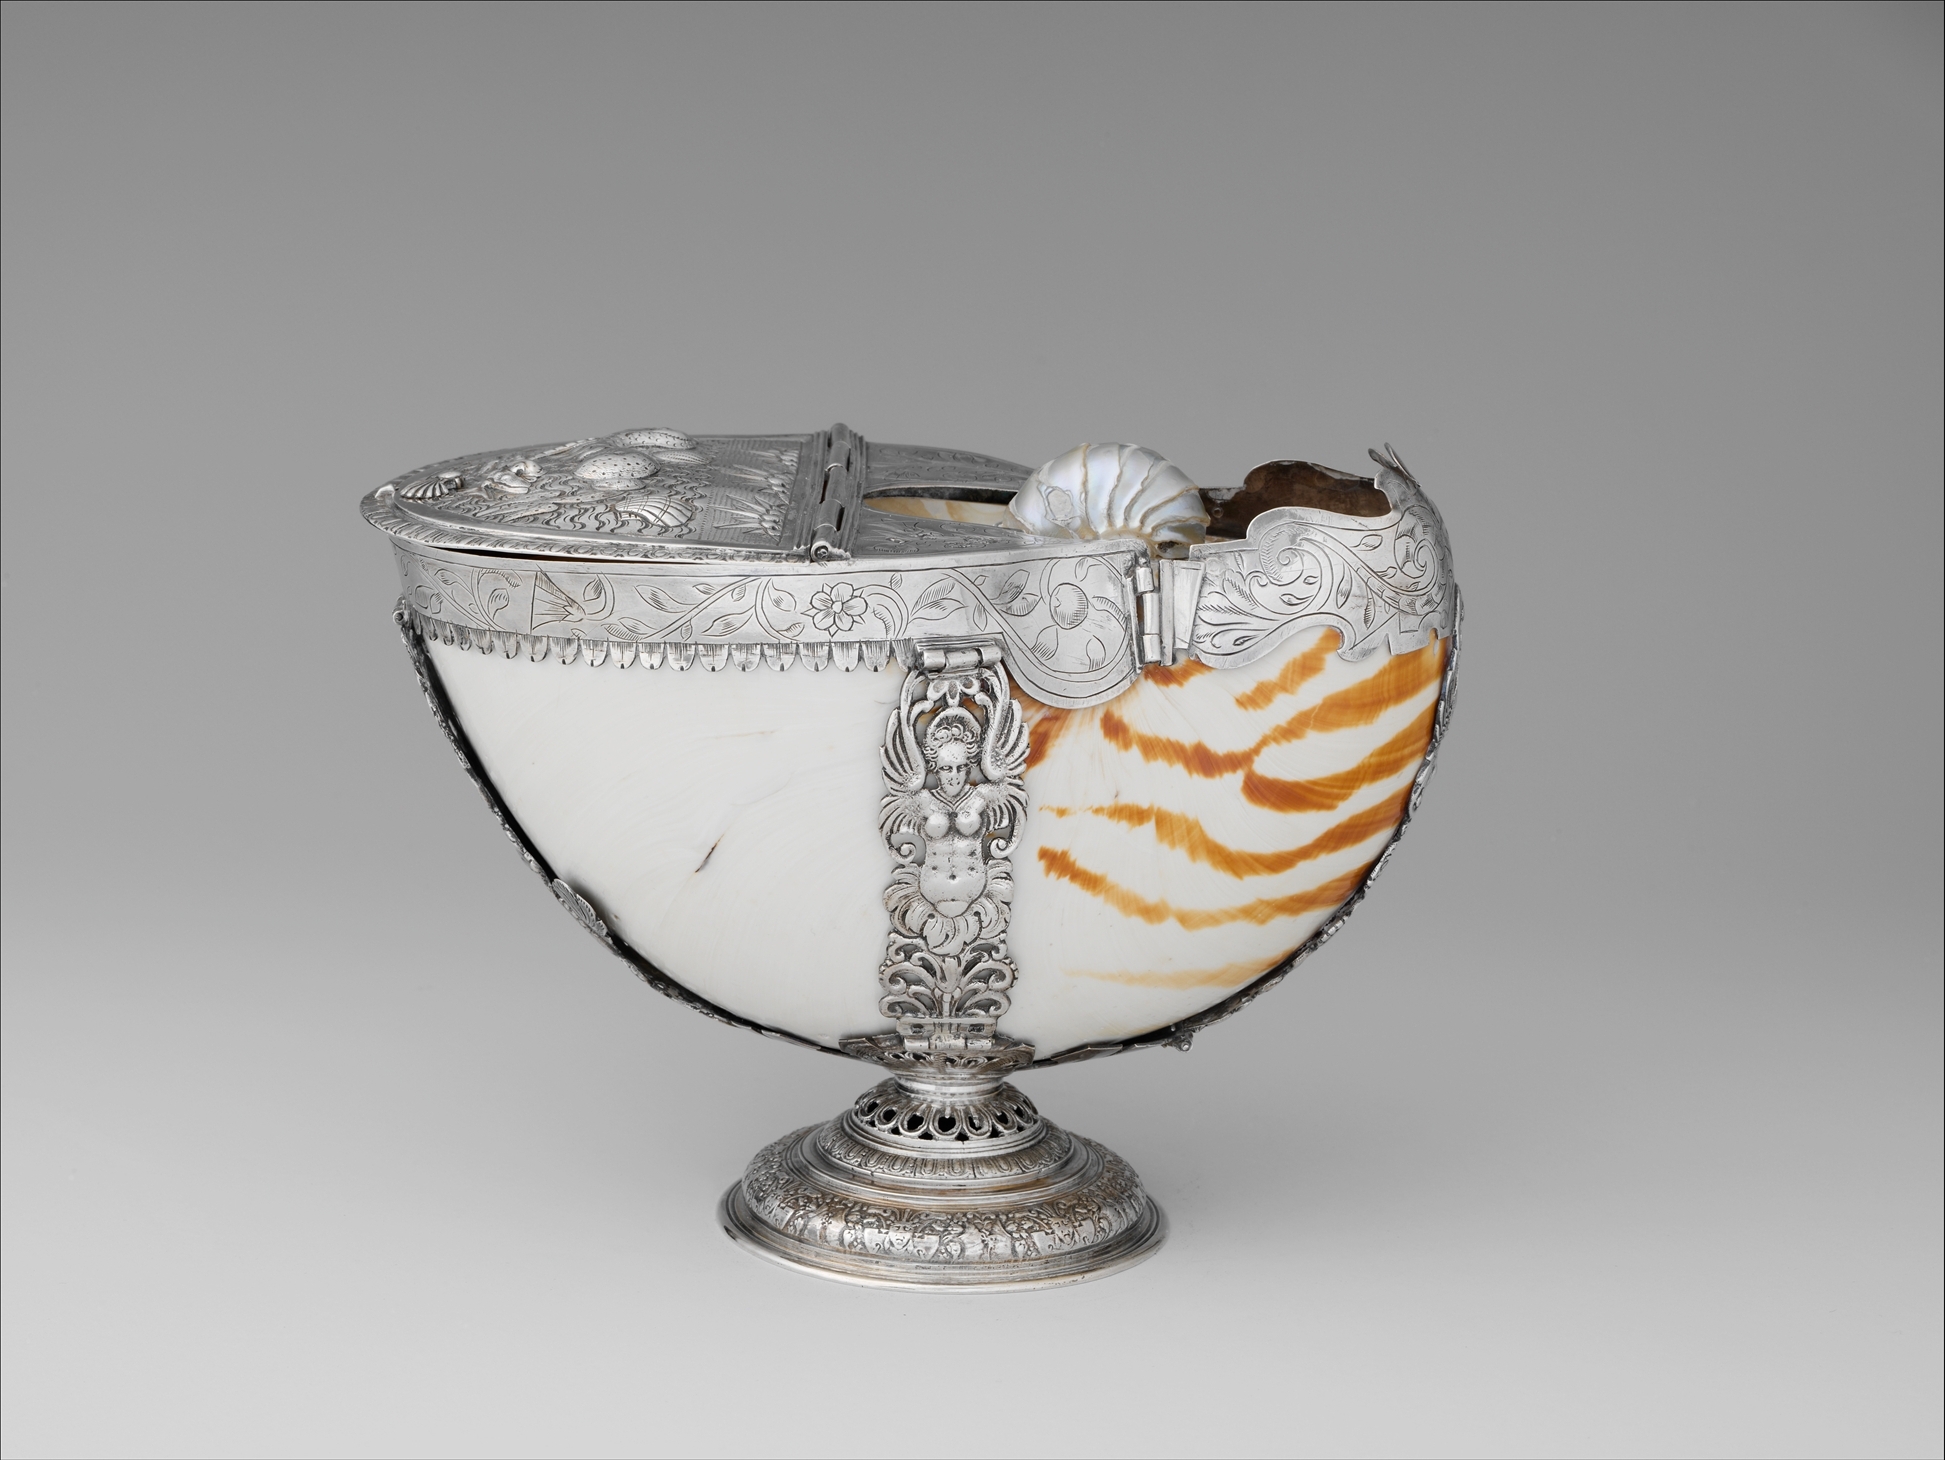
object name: box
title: Nautilus shell box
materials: shell, silver